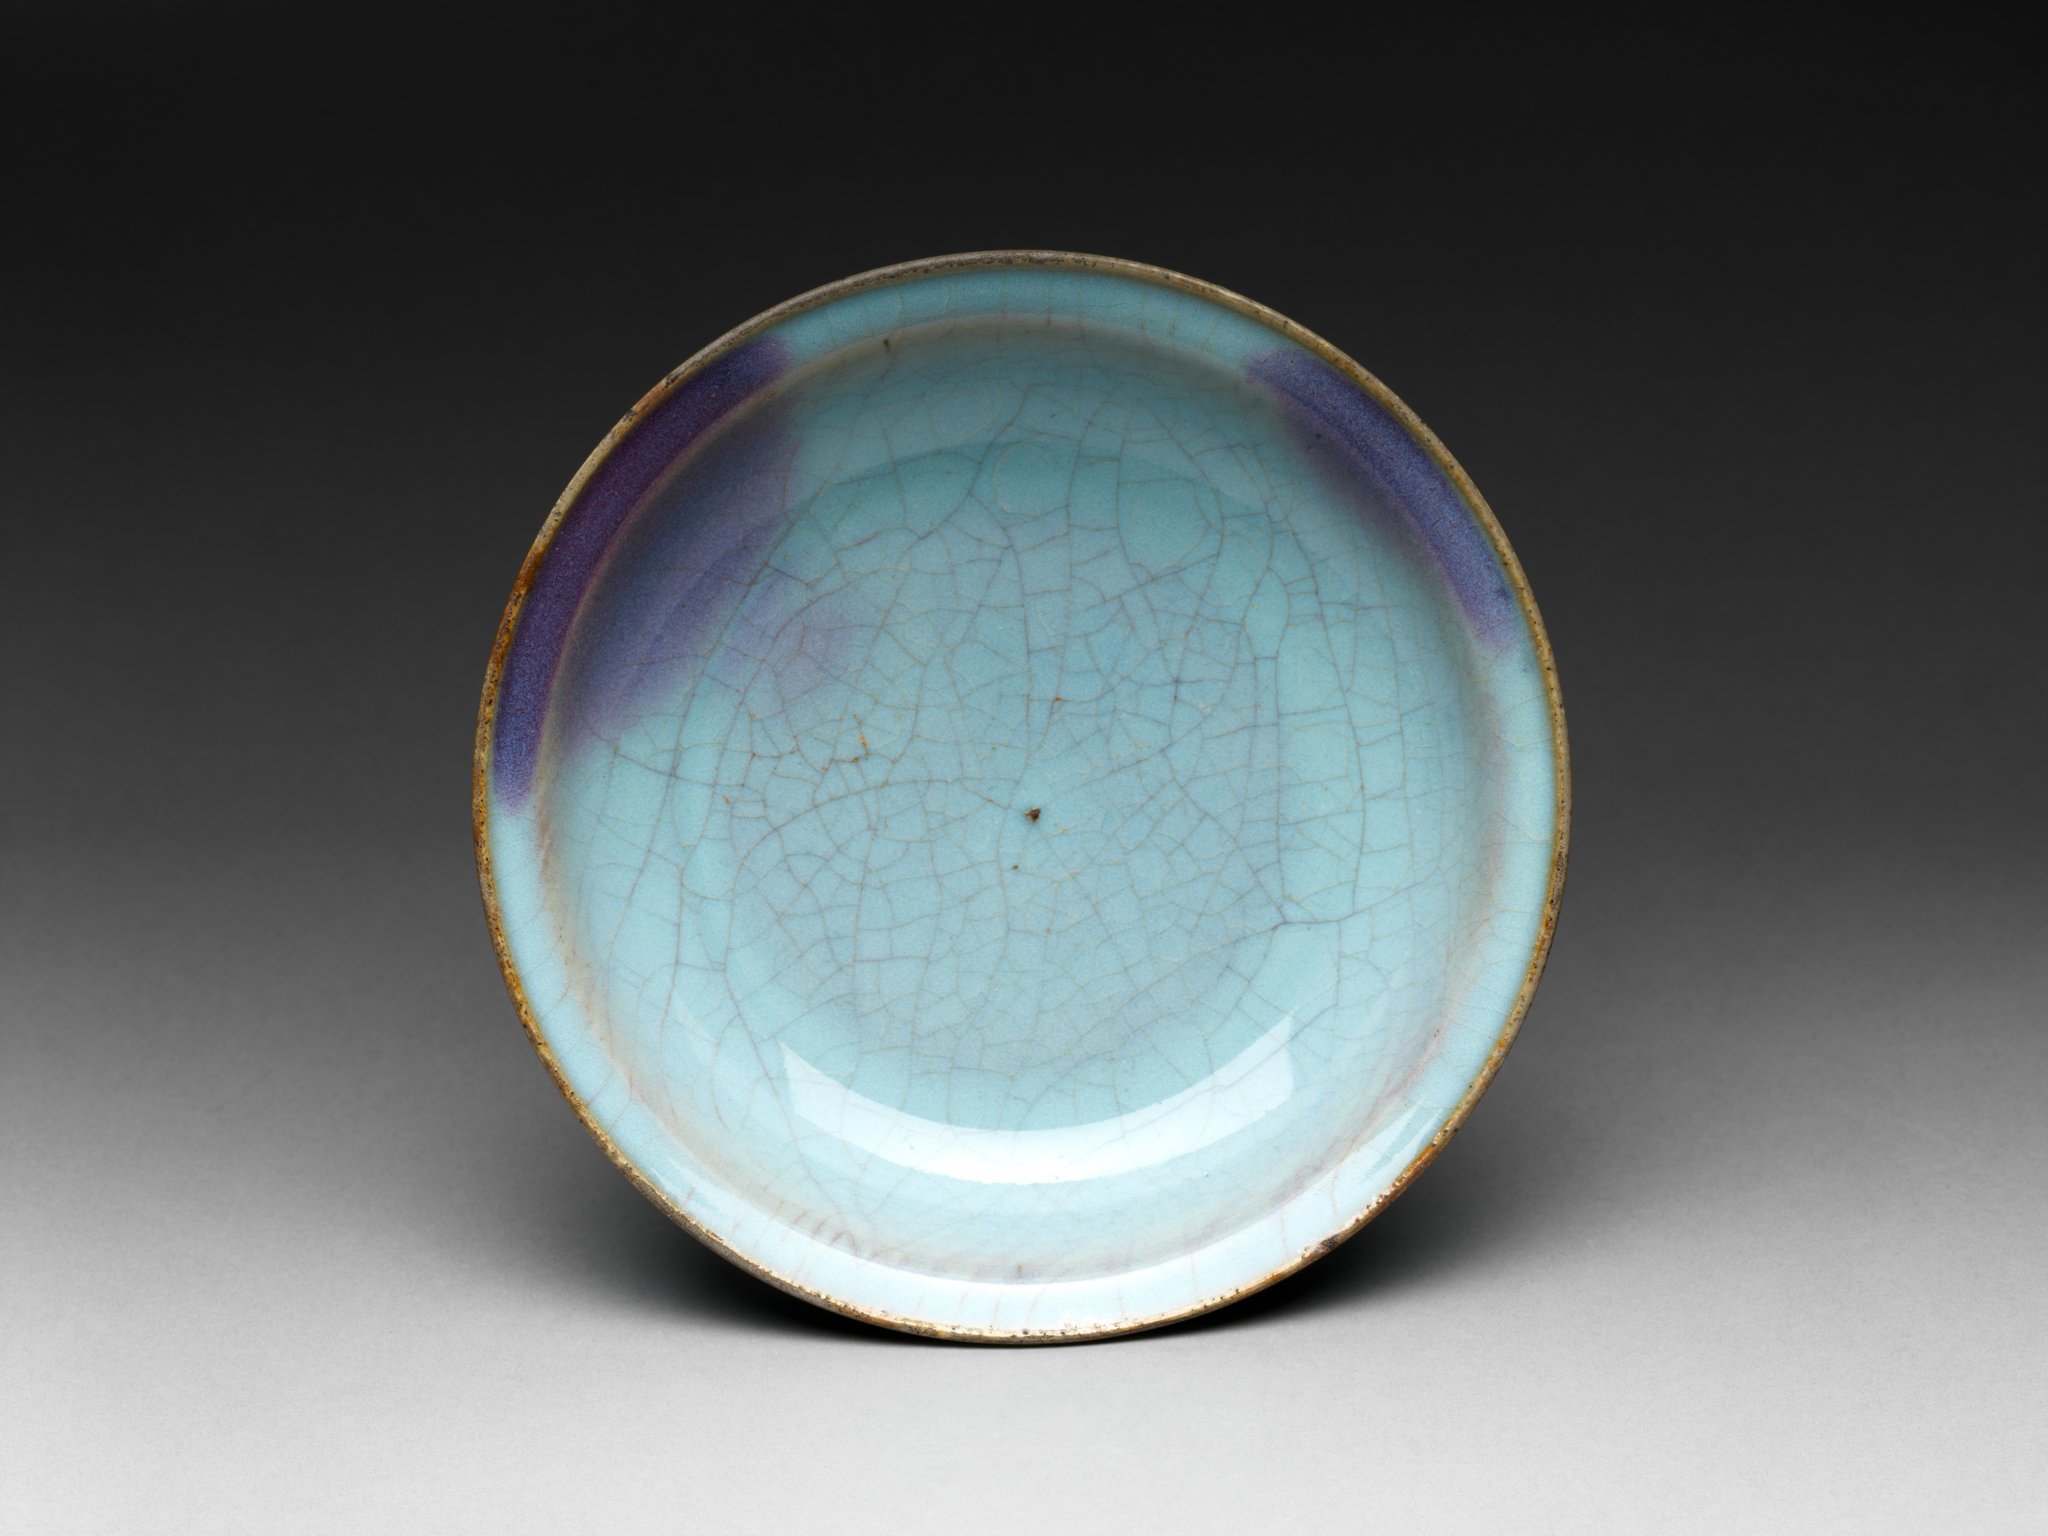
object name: plate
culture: chinese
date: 1001-1200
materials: pottery